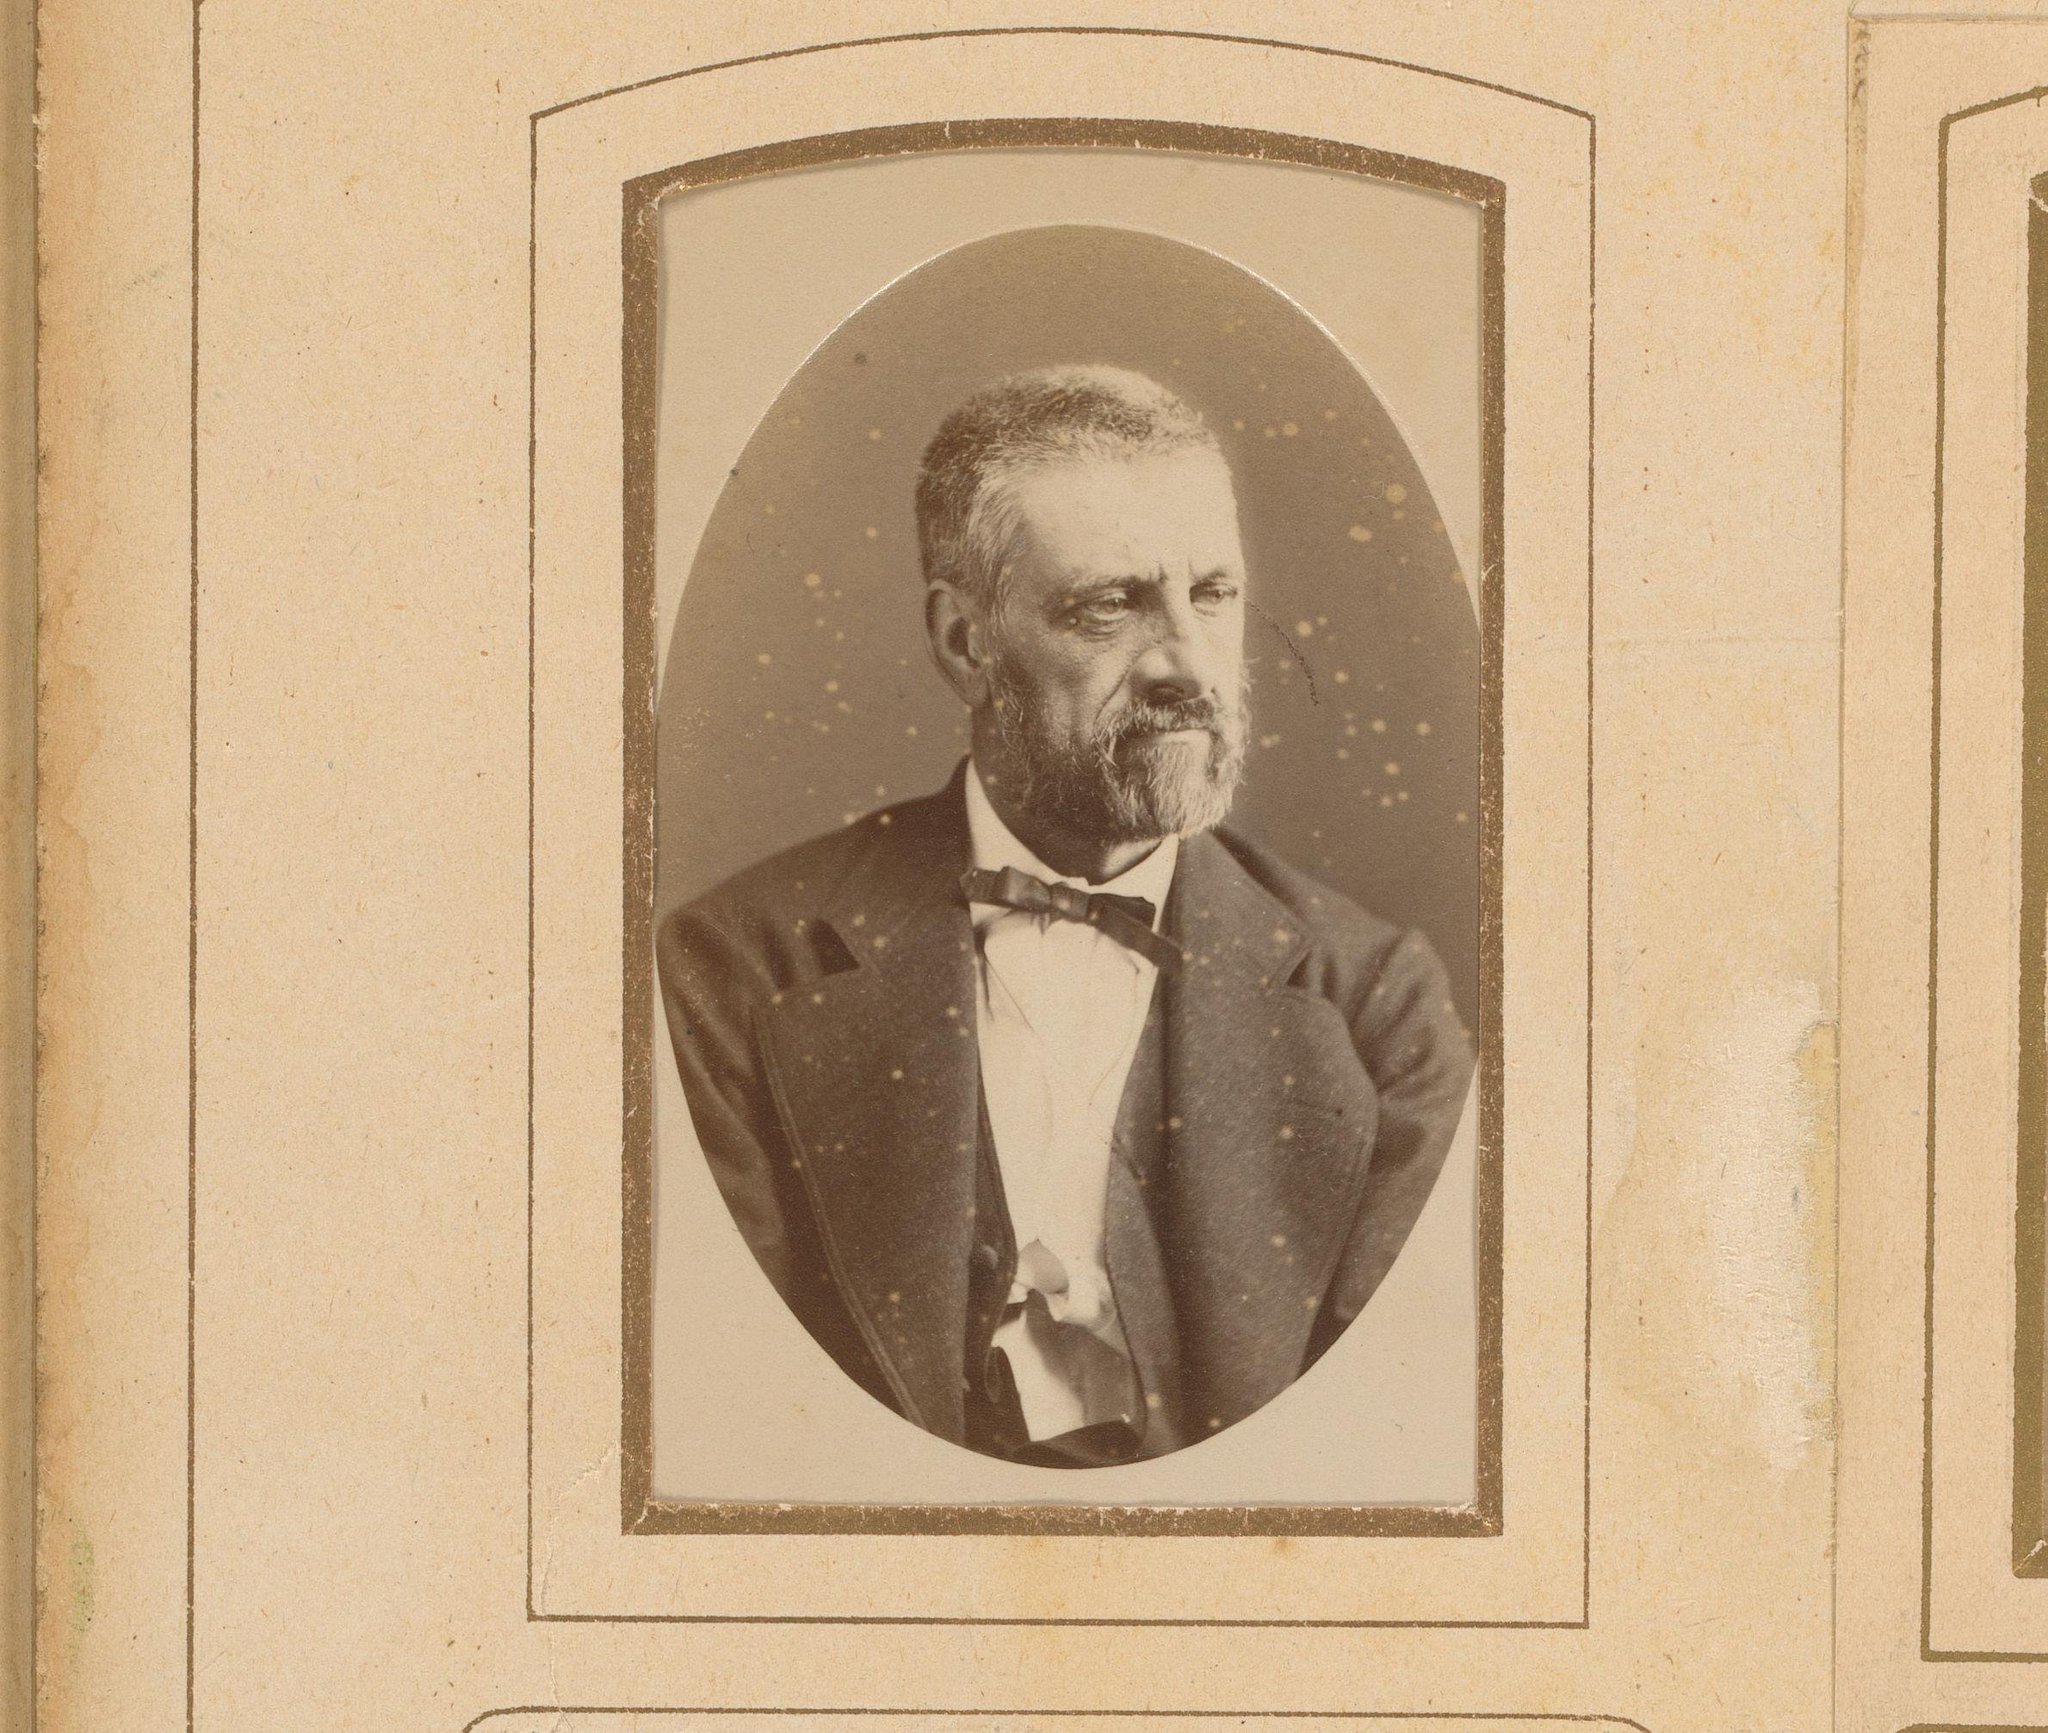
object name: album leaf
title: Portret van een man met snor, baard en vlinderstrik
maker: parkinson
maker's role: fotograaf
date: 1860-1900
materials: cardboard, photographic support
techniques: albumen print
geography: dieppe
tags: moustache, historical persons, beard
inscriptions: inscription: ‘PARKINSON/ PHOTOGRAPHER TO THE QUEEN/ & hoble board of admirality/ RUE AGUADO/ DIEPPE’